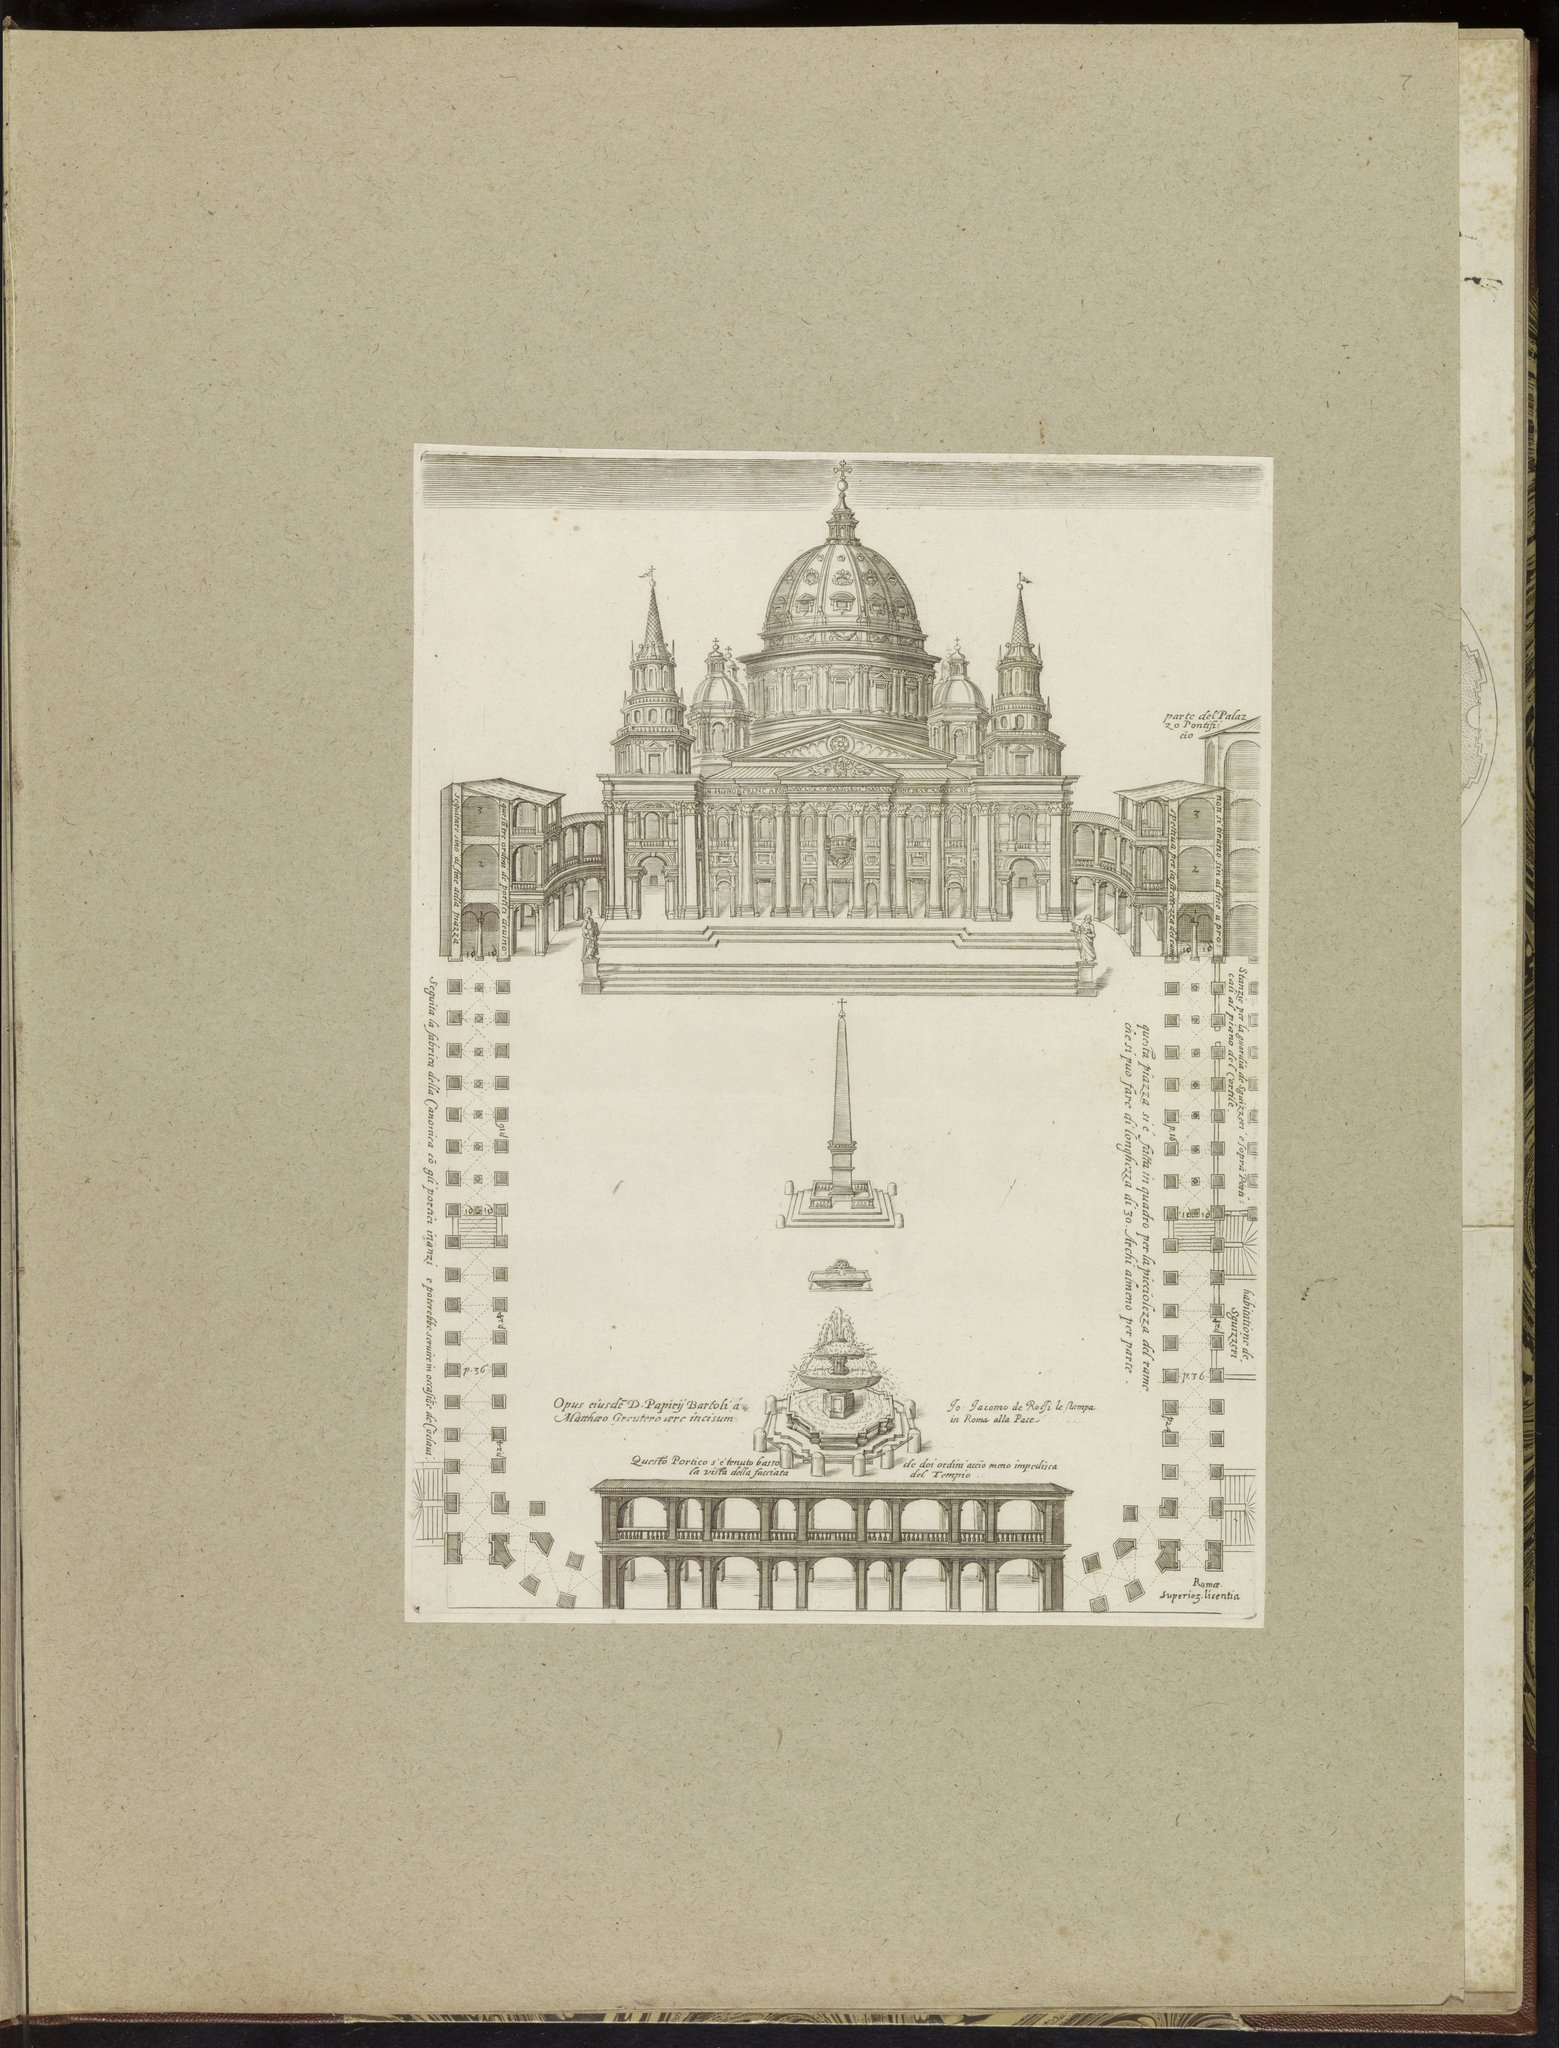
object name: print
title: Gevel en plein voor de Sint-Pietersbasiliek te Vaticaanstad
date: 1637-1691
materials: paper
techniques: engraving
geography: italy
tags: church (exterior), roman catholic church, parts of church exterior and annexes: façade